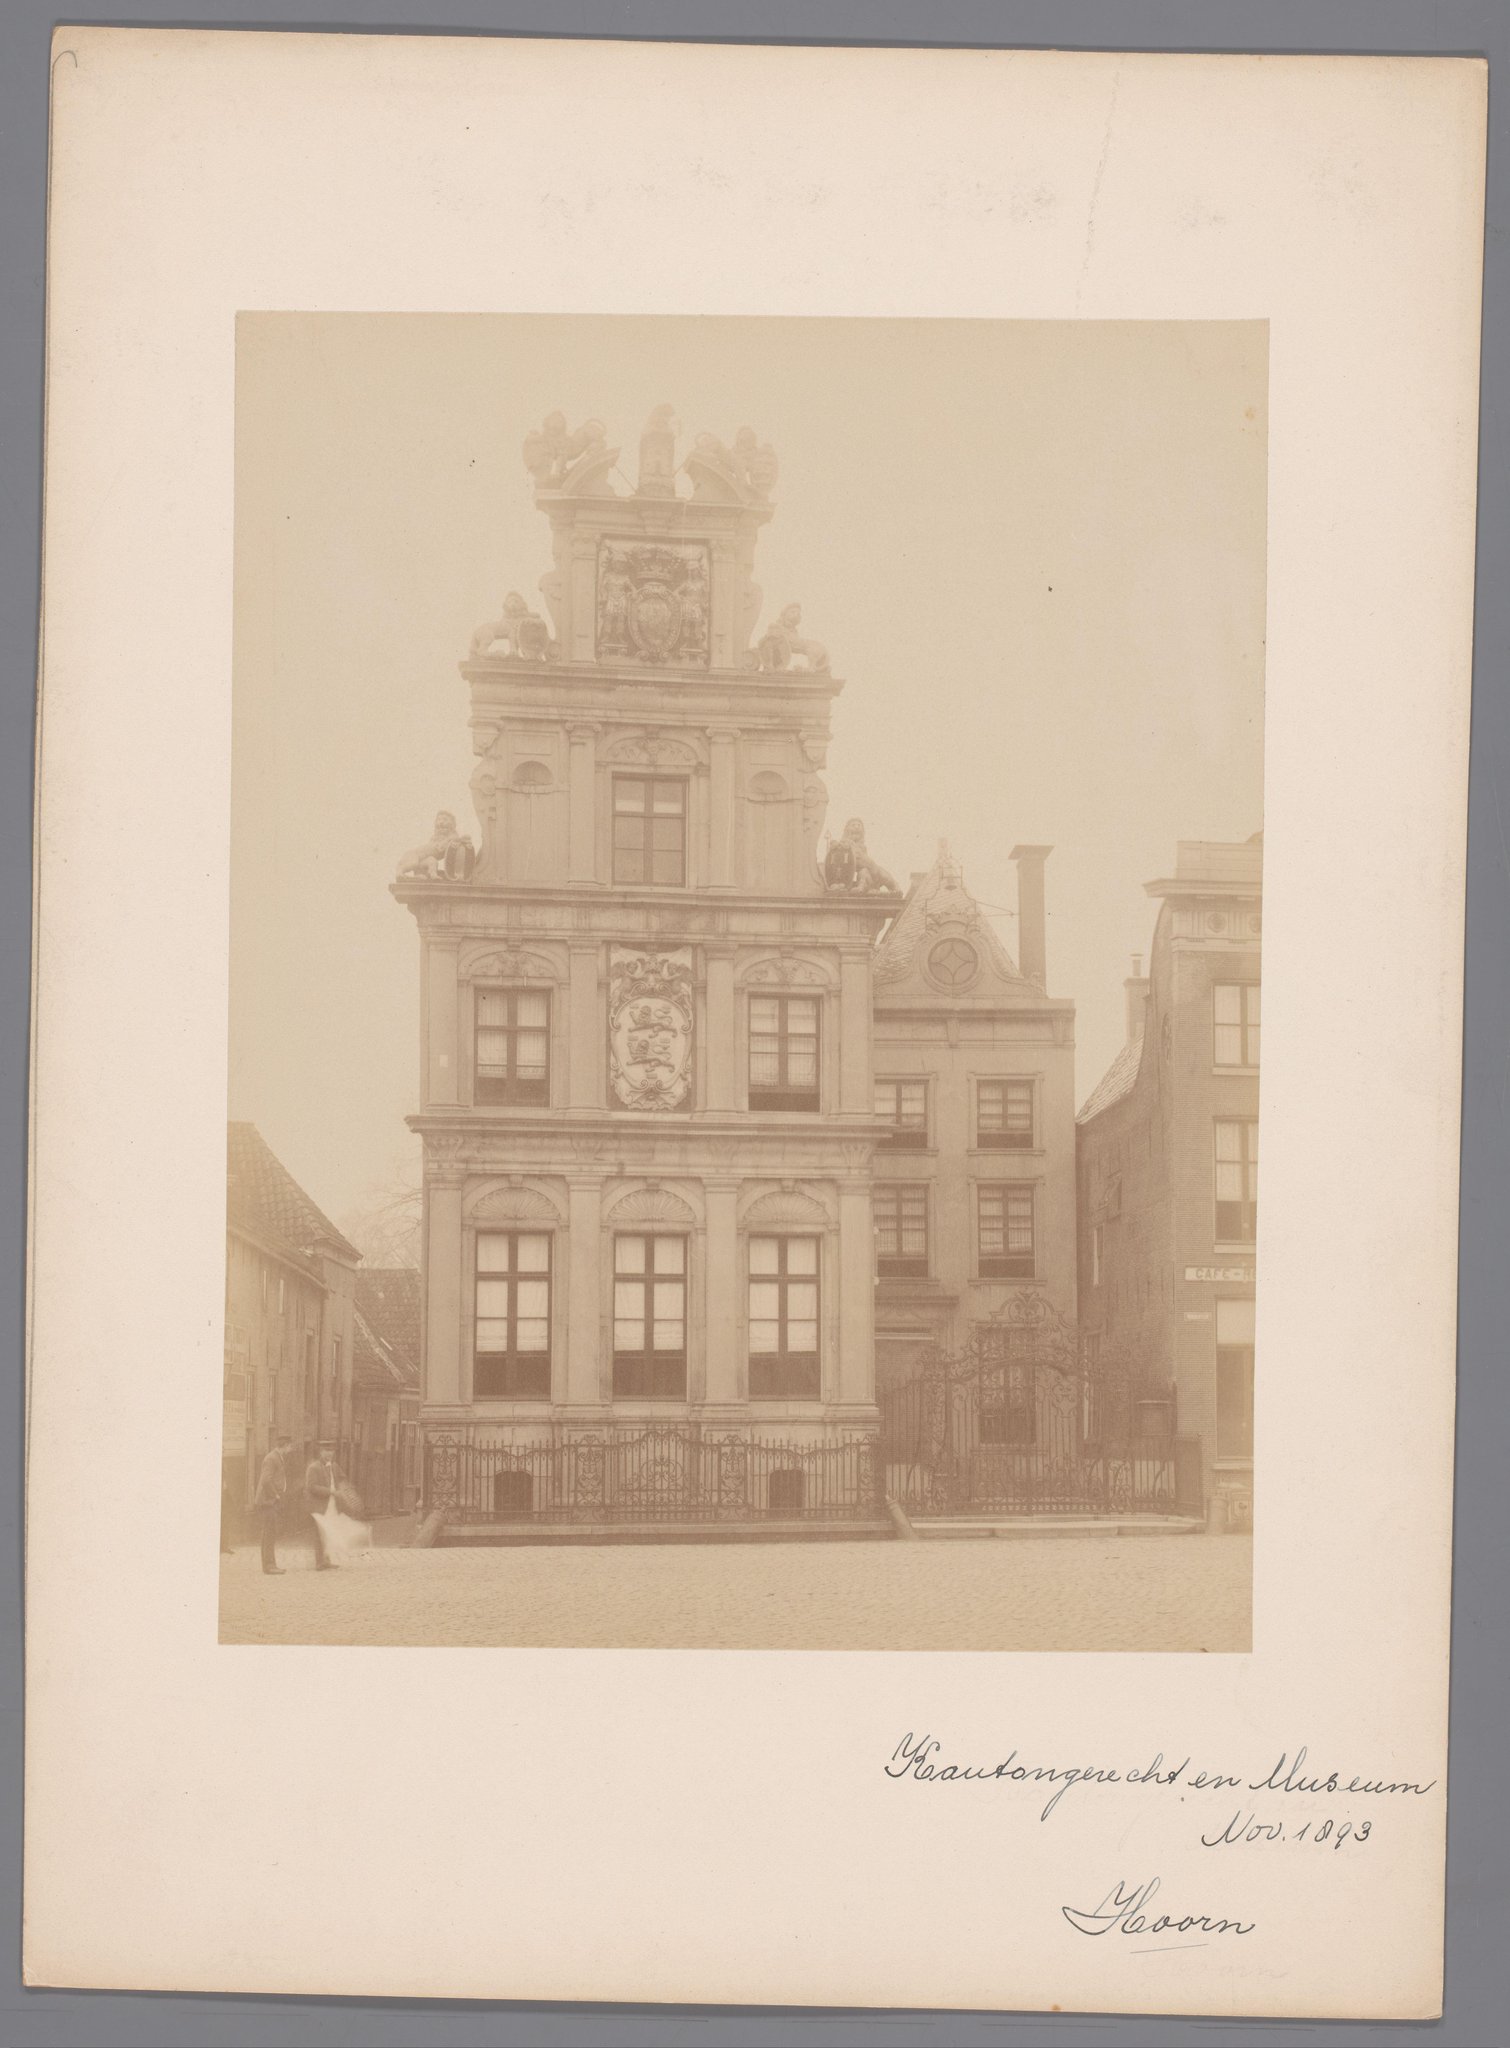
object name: photograph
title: Gezicht op het Westfries Museum te Hoorn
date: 1893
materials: cardboard, photographic support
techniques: albumen print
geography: roode steen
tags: permanent exhibition, museum, façade (of house or building)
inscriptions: annotation: ‘Kantongerecht en Museum/ Nov. 1893/ Hoorn’, annotation: ‘Hoorn (N.H.)/ Kantongerecht en Museum/ Nov. 1893’